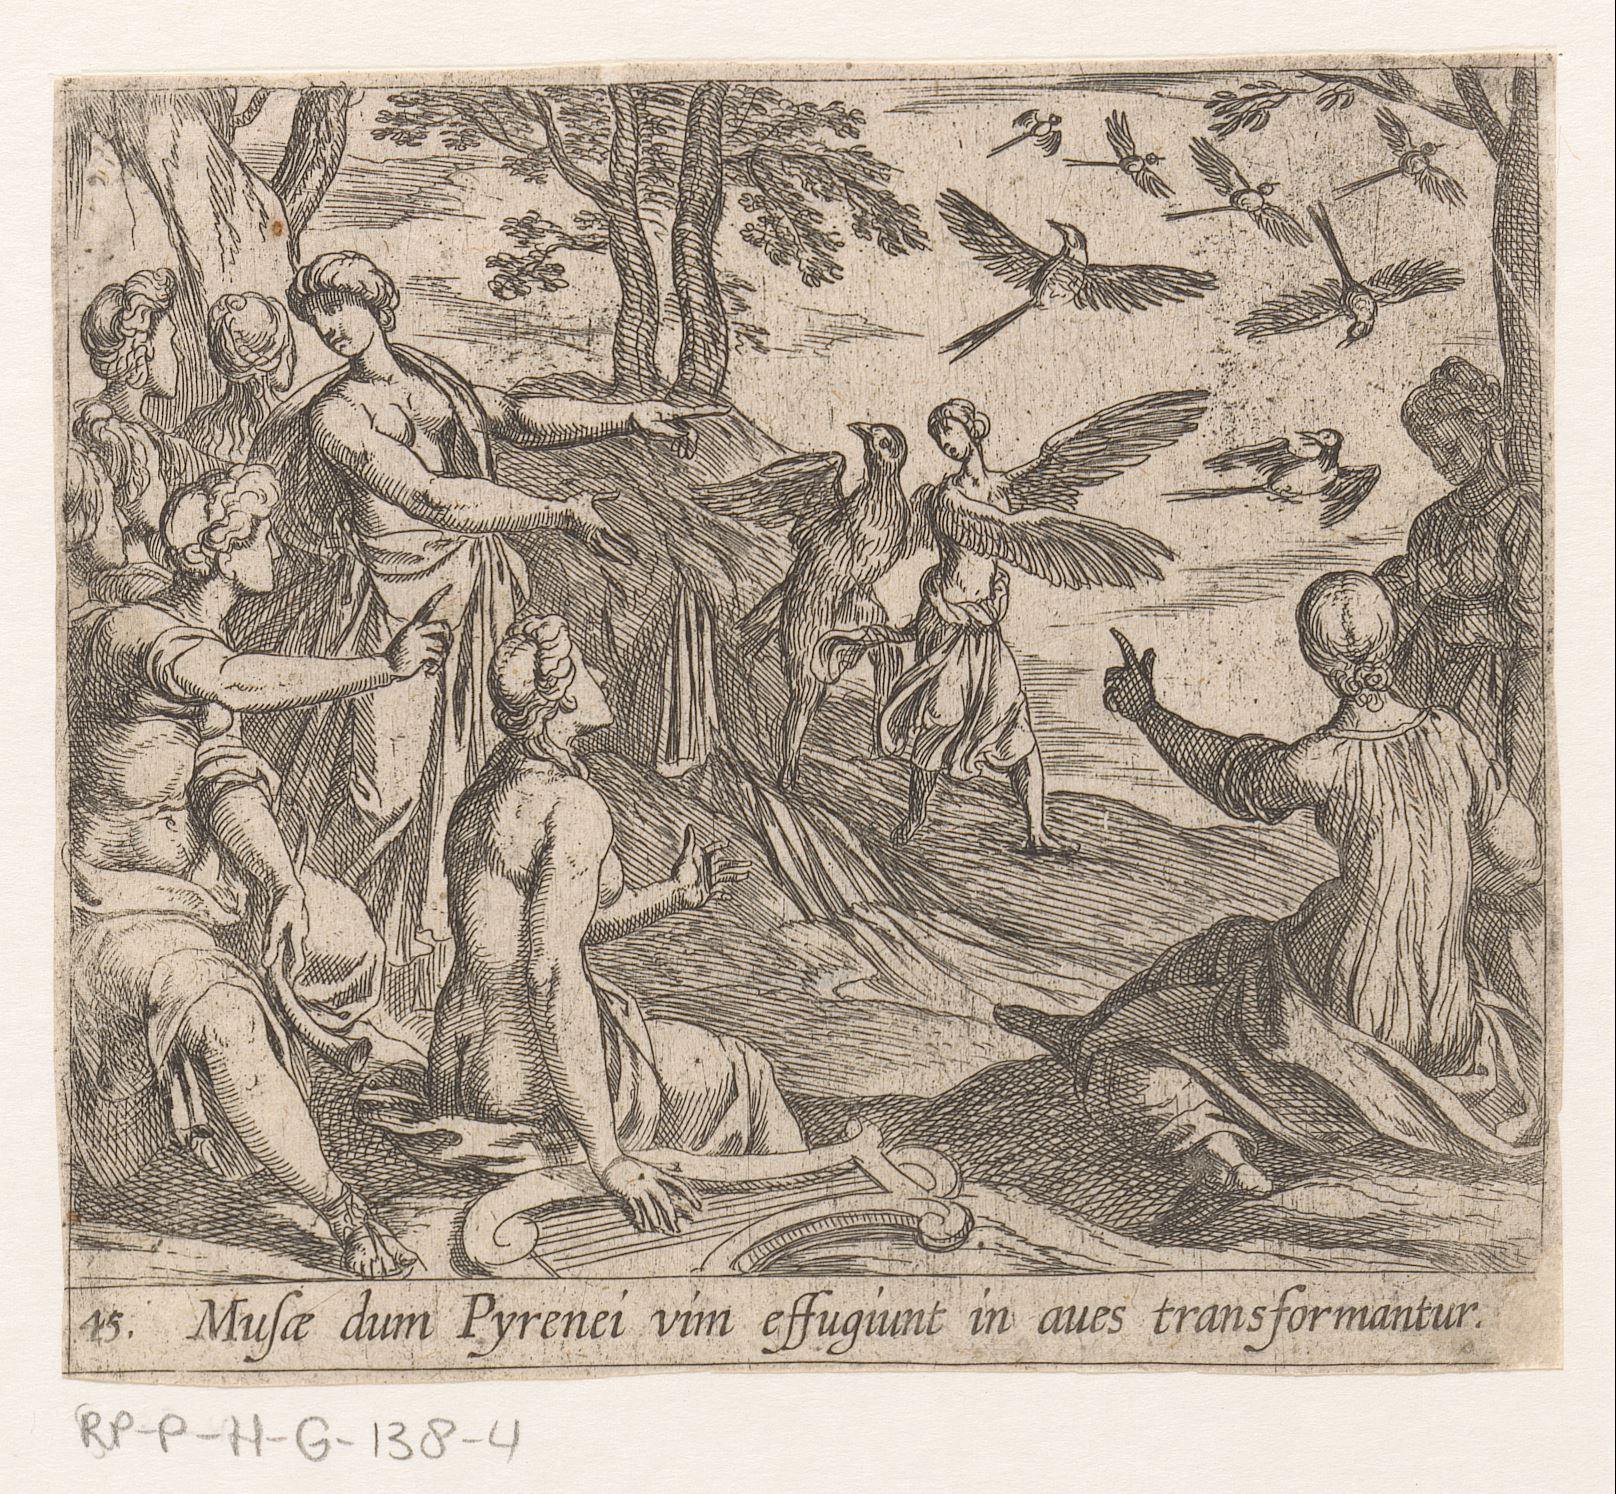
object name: print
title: Metamorphoseon sive transformationum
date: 1606-1638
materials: paper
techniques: etching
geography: amsterdam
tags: pierides changed into magpies: the pierides (emathides) are changed into magpies by the muses, who have defeated them in a musical contest (ovid, metamorphoses v 670)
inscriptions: collector's mark: ‘Hinloopen’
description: Deze prent maakt deel uit van een reeks van 150 prenten (+ titelprent) met voorstellingen van de Metamorfosen van Ovidius.